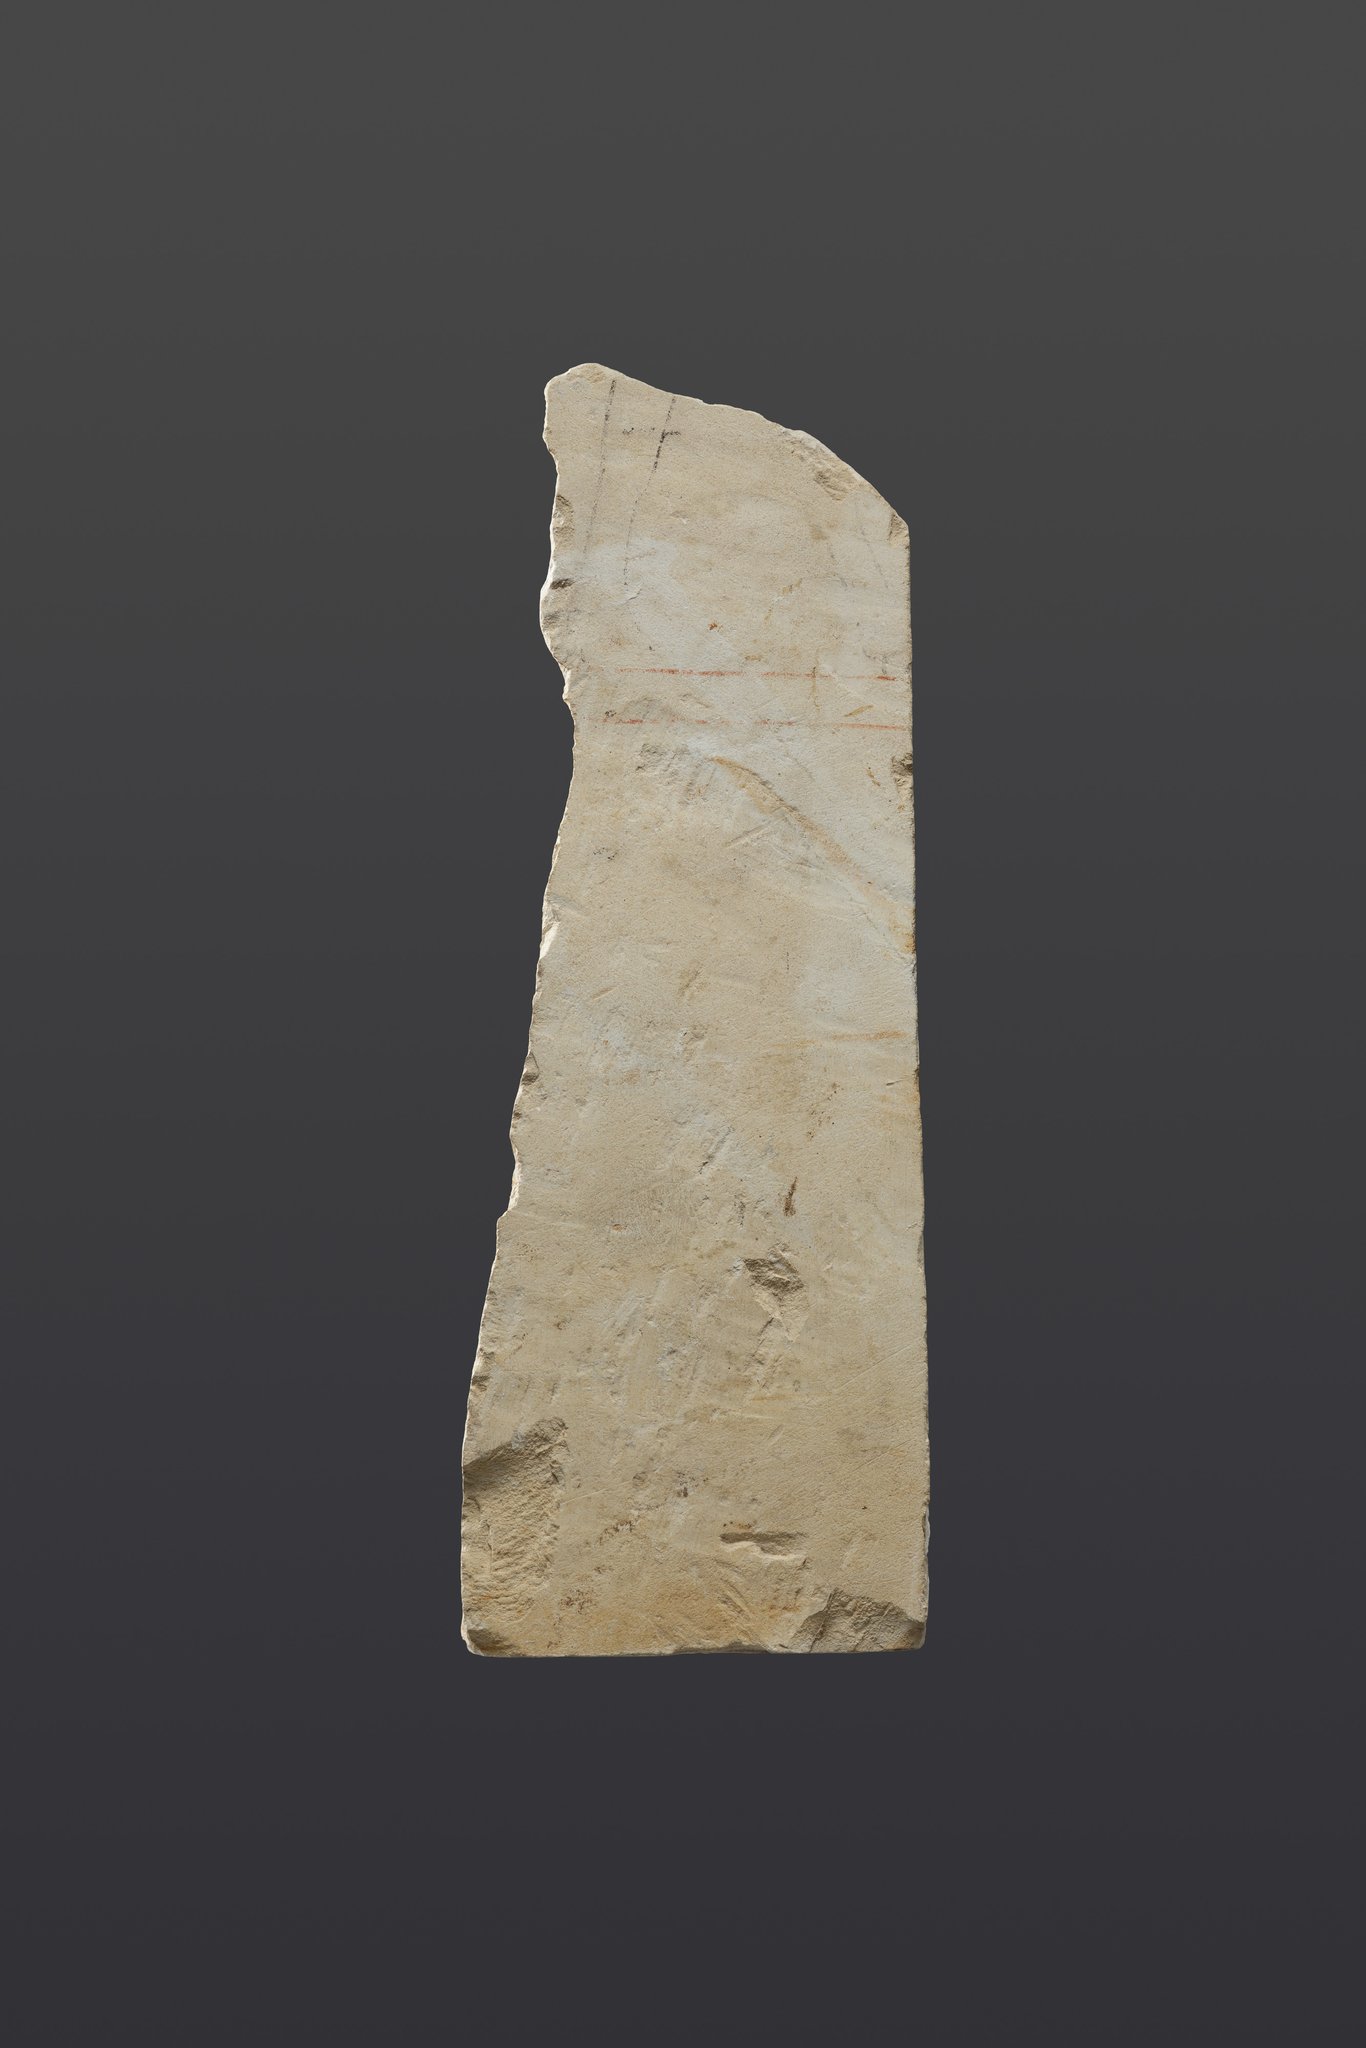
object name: relief drawing, sebeknakhte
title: Preliminary drawing for a relief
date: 2124-1504 BCE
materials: limestone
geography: egypt